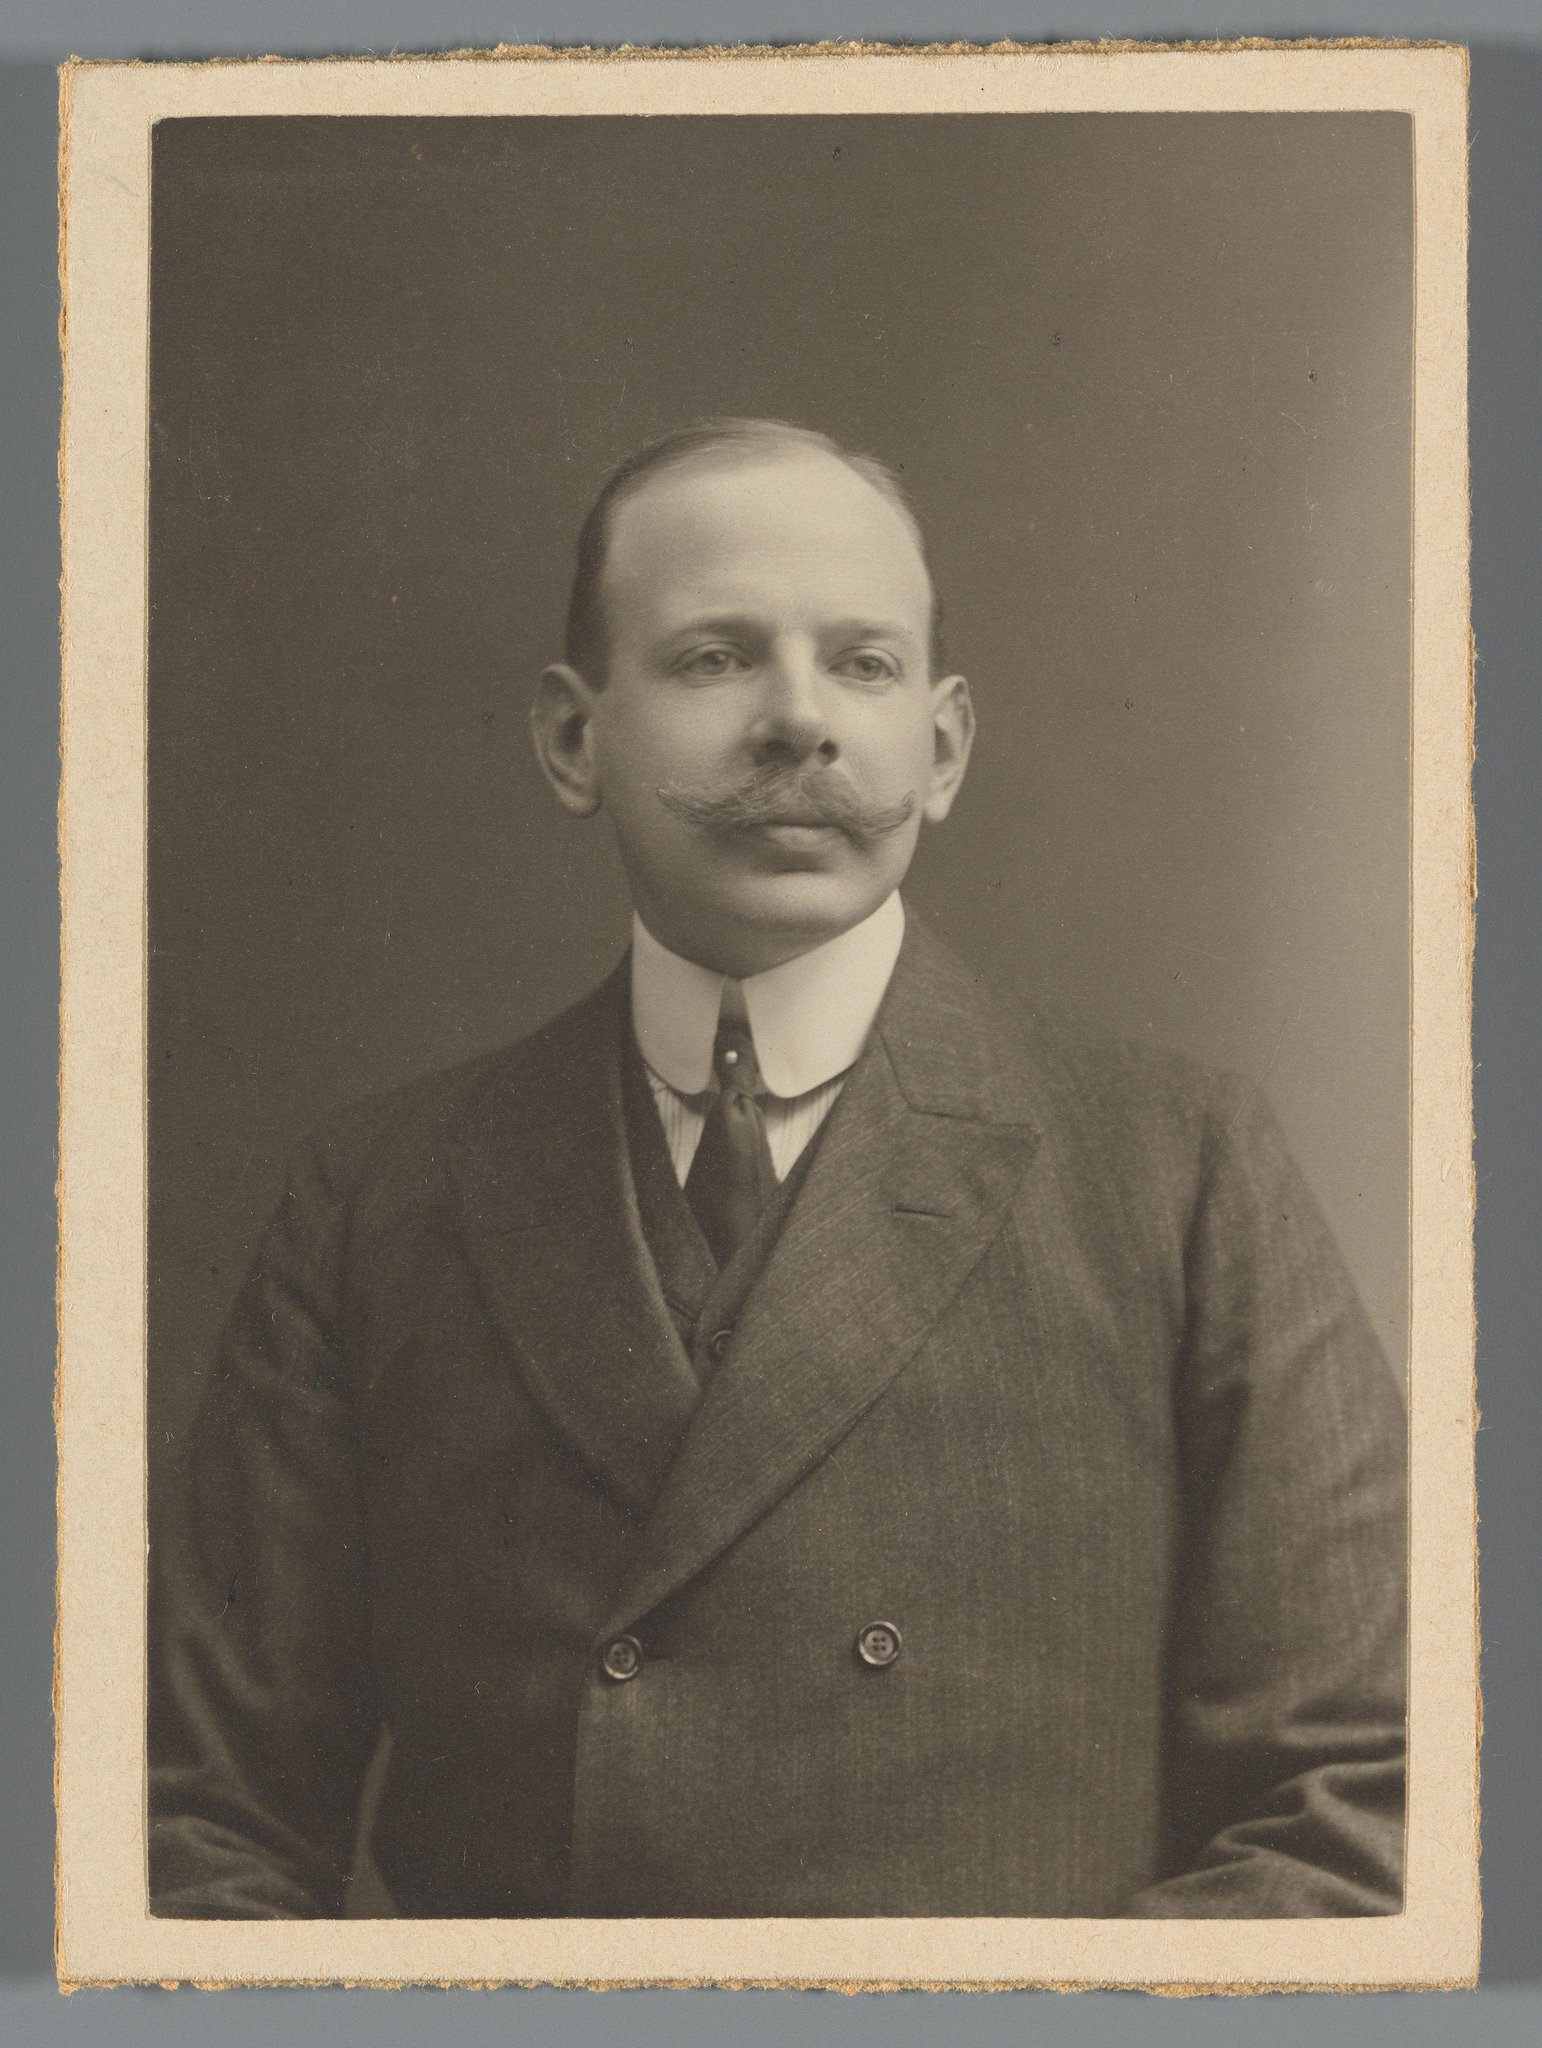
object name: photograph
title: Portret van Karel Frederik van den Berg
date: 1895-1915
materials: photographic support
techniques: photography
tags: batavia, karel frederik van den berg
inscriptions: name: ‘K. Tauts & Co. / Specialität: Rahmenleisten / MERAN / Habsburgerstrasse 16’